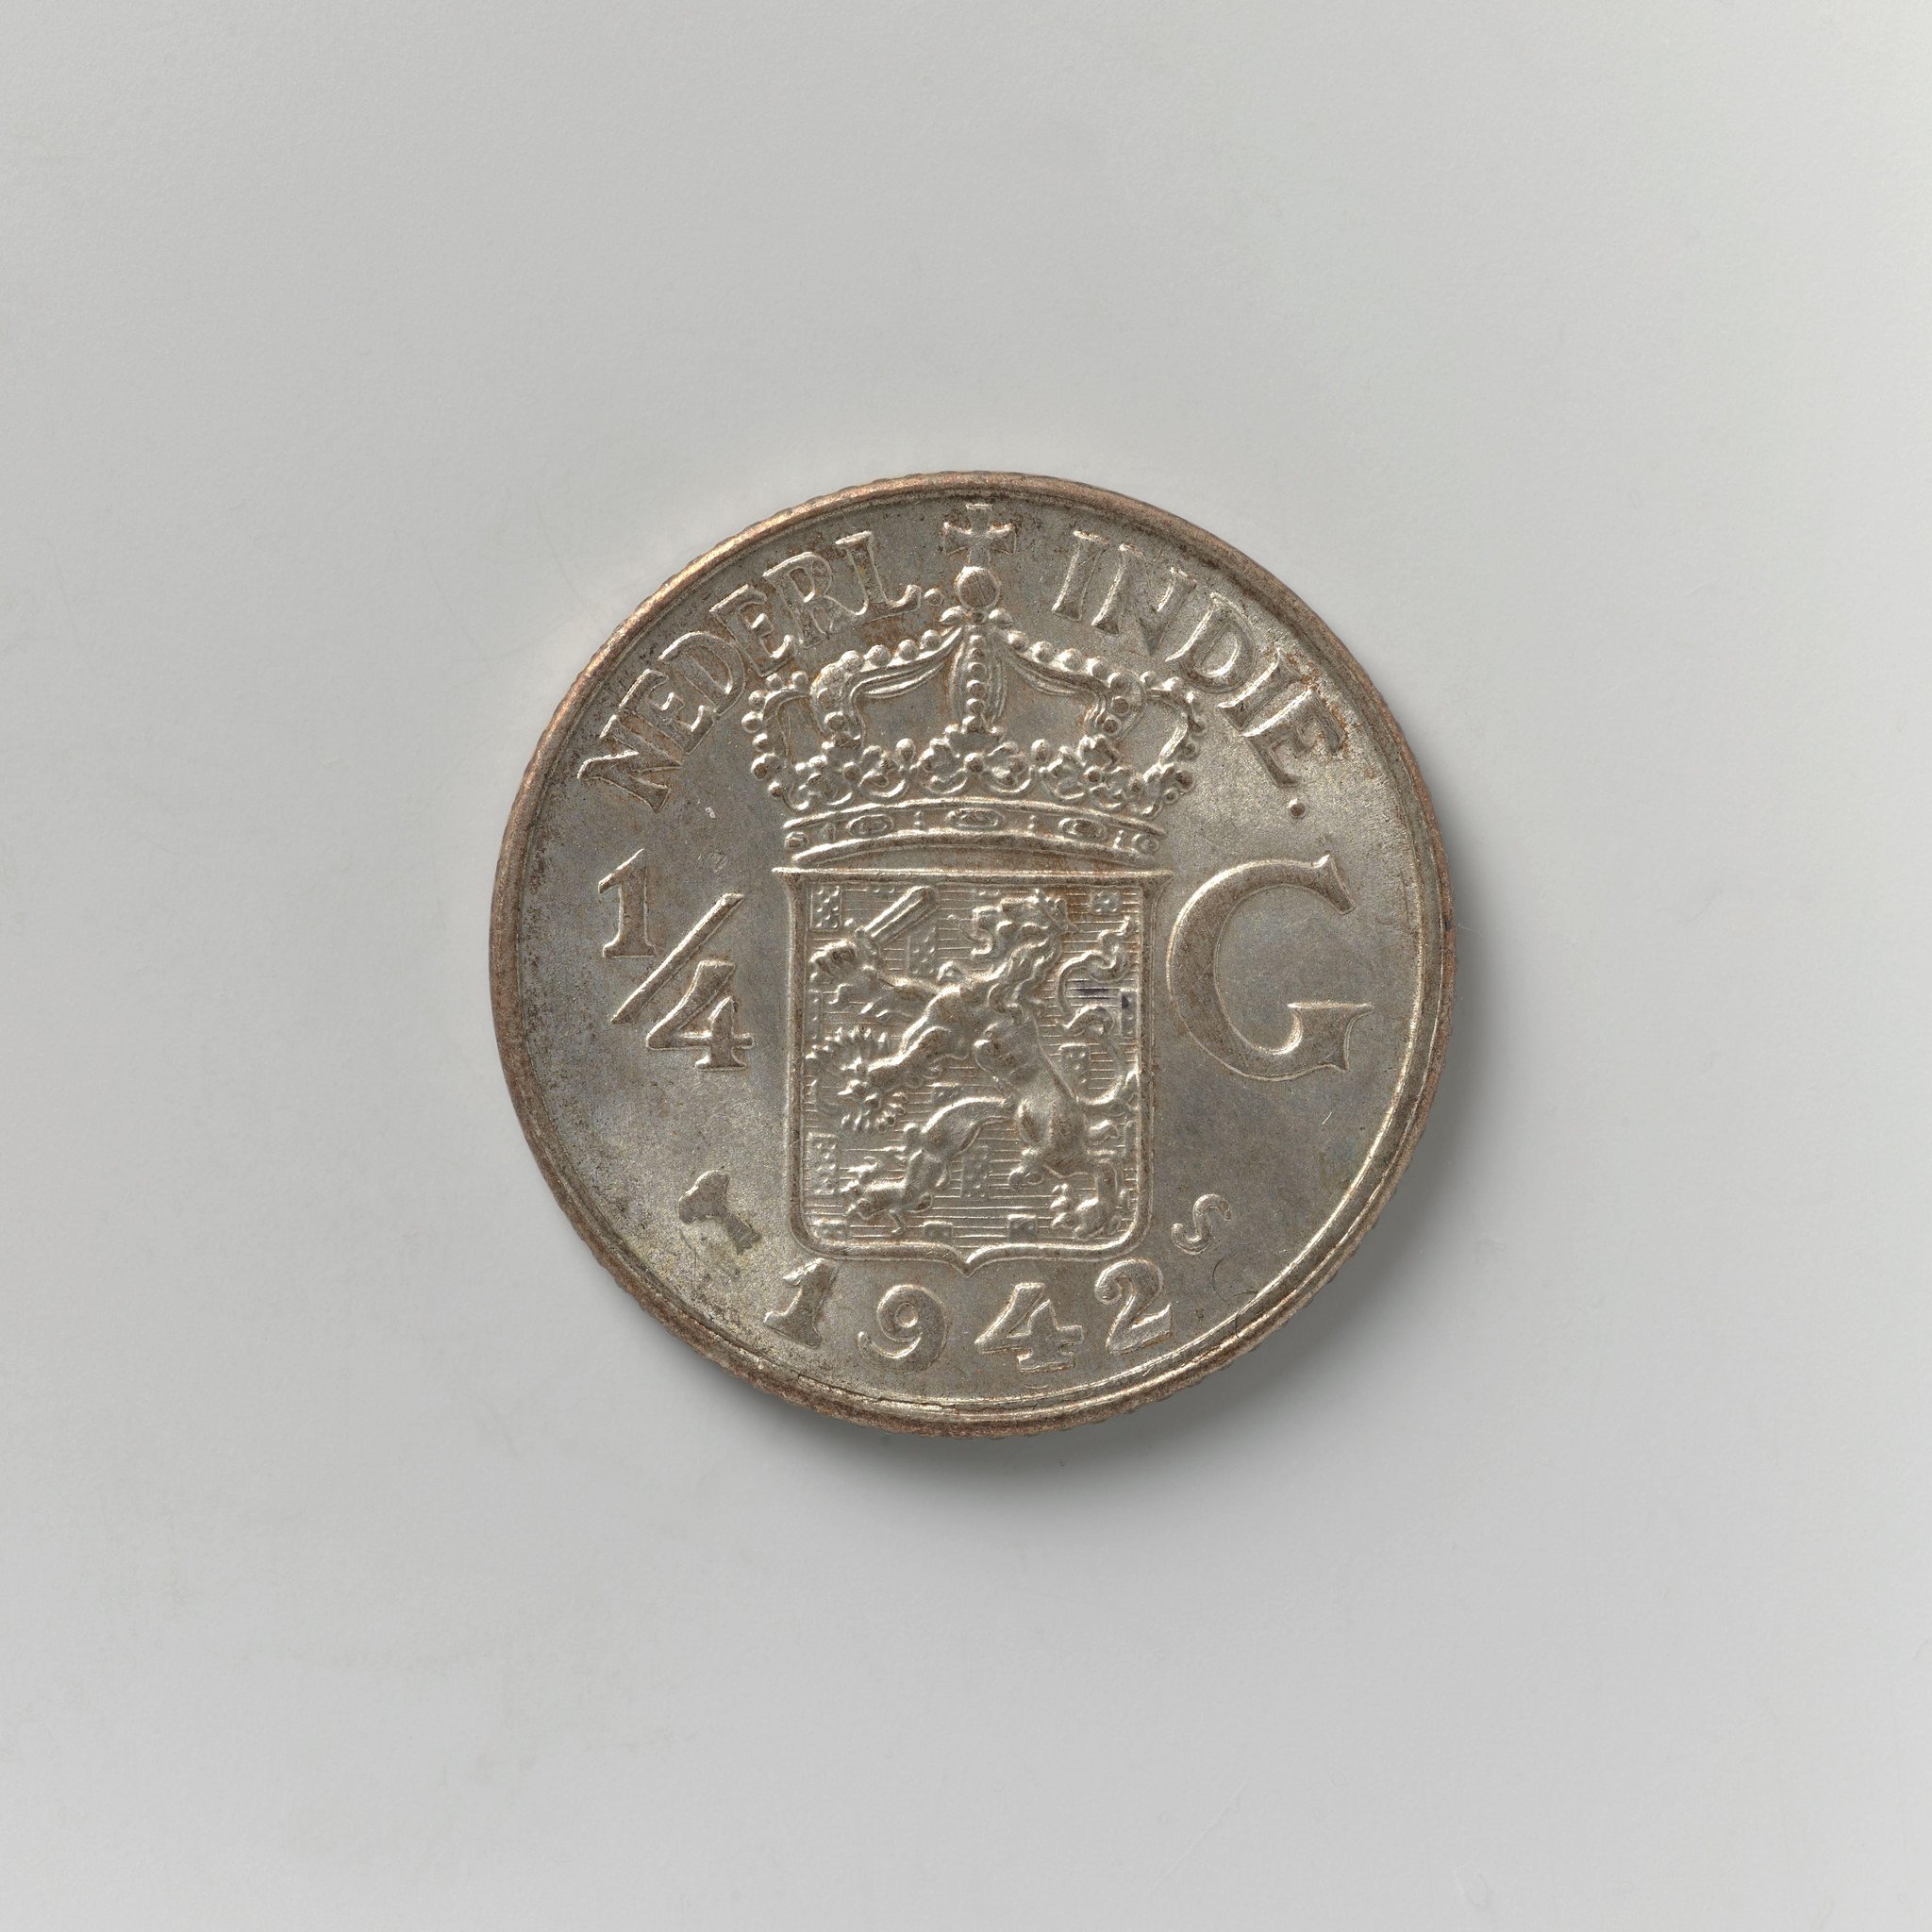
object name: coin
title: Nederlands Indië,1/4 gulden,1942 S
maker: wilhelmina of the netherlands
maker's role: print maker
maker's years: 1880-1962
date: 1942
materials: silver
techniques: striking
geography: san francisco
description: Zilveren munt. Voorzijde: tussen waarde-aanduiding 1/4 G gekroond rijkswapenschild. Boven kroon landsaanduiding en onder wapenschild jaartal. Keerzijde: drieregelig Maleis opschrift in Arabische tekens, waaromheen tussen zeven uitschietende stralen omschrift in het Javaans. Kartelrand.